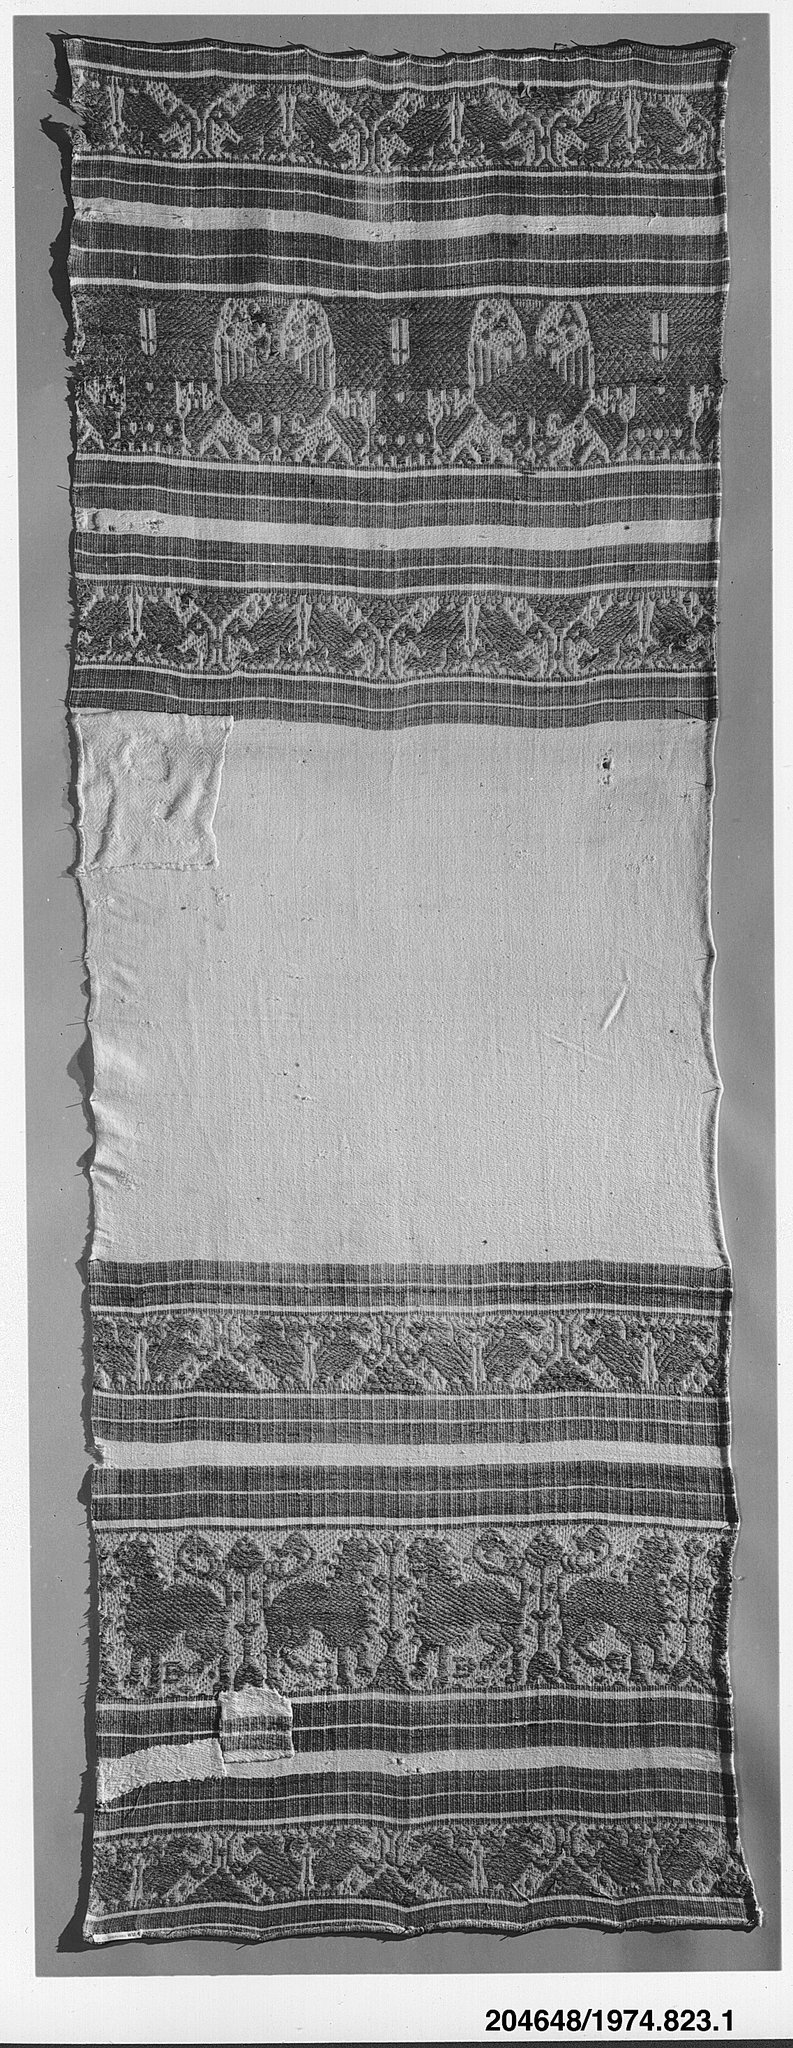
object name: towel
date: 1401-1600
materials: cotton, linen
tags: animals